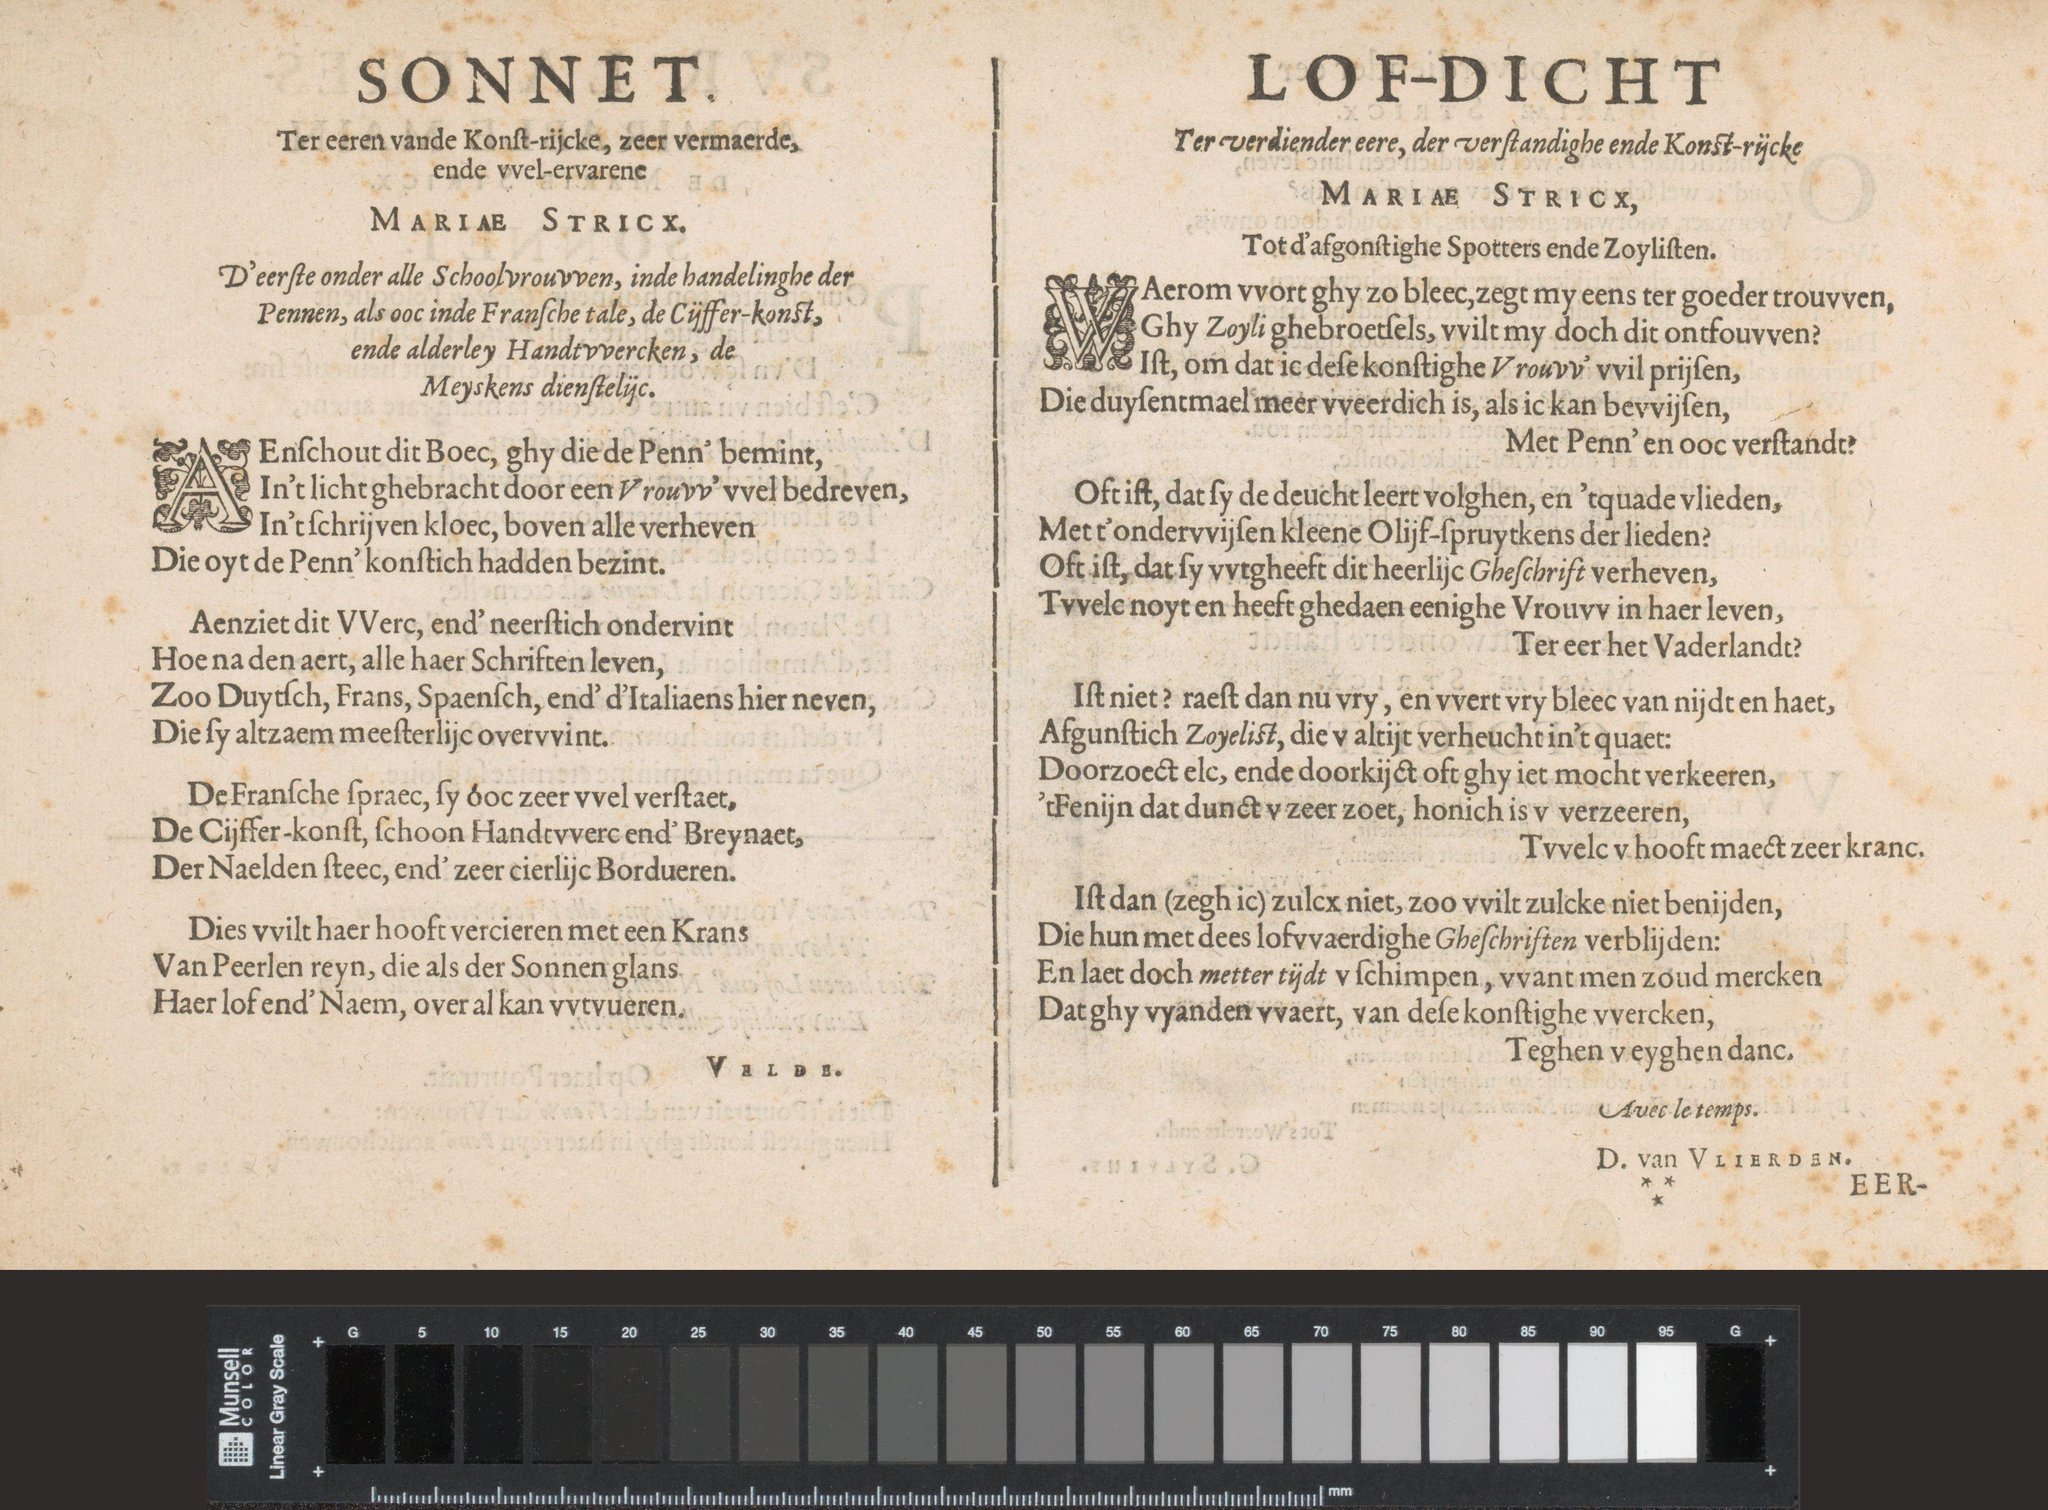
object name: print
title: Twee drempeldichten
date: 1618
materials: paper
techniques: letterpress printing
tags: initial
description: Twee drempeldichten als inleiding bij een serie kalligrafische schrijfvoorbeelden van Maria Strick, beide in het Nederlands en beginnend met een gedecoreerde initiaal. Het blad maakt deel uit van een album.